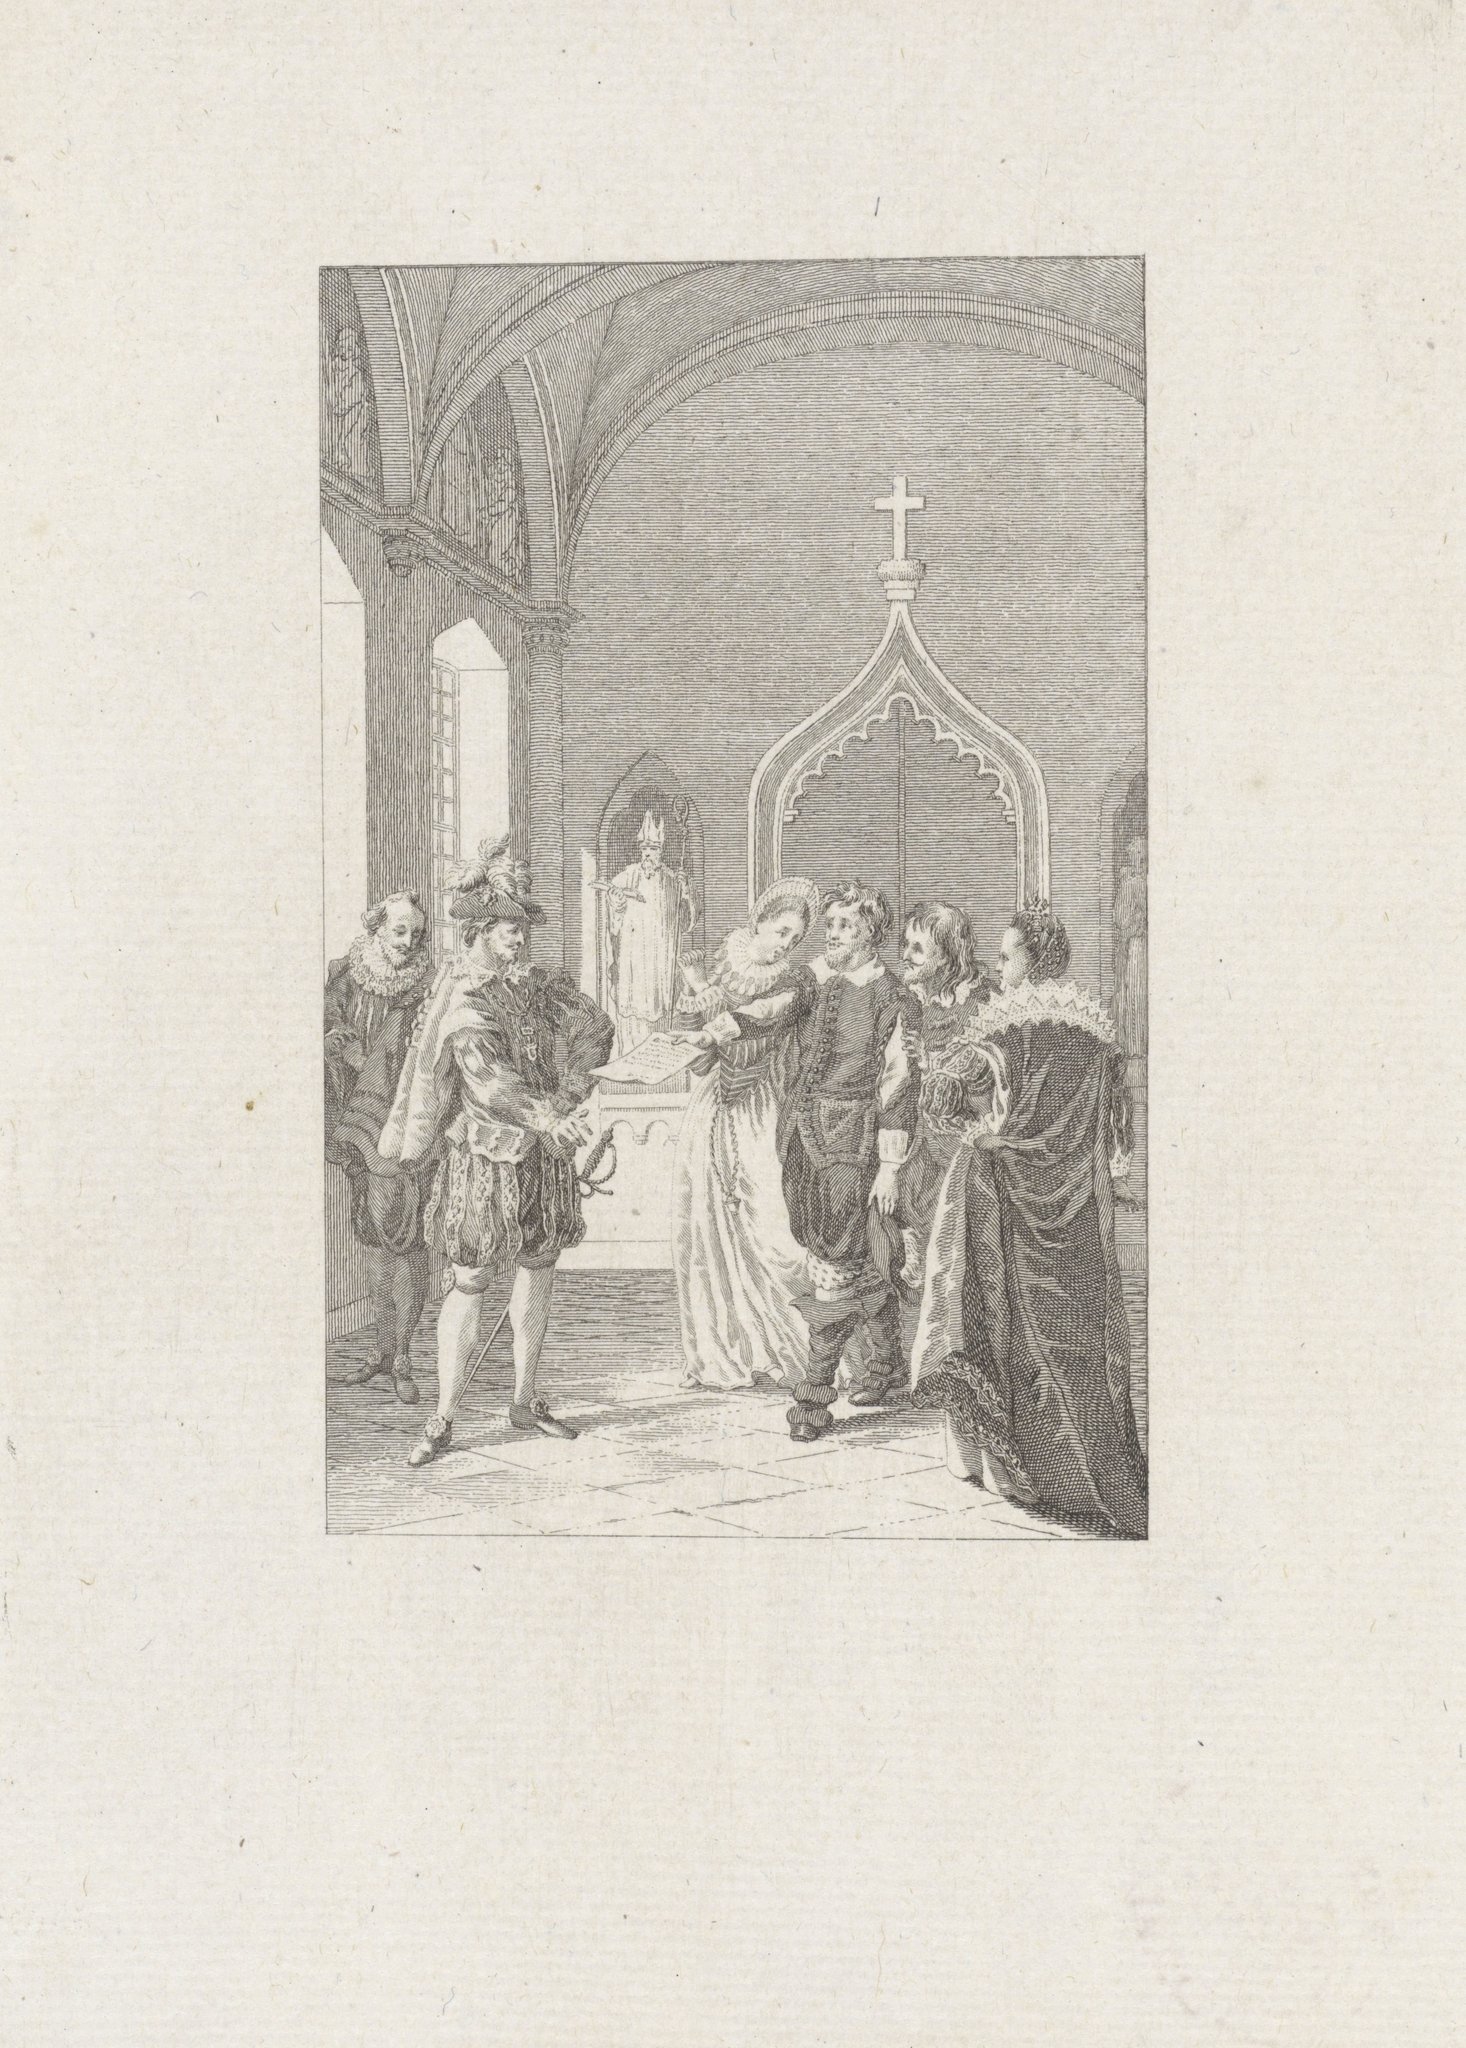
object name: print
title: Jacob Simonsz de Rijk geeft zijn ontslagbrief terug aan Cristóbal de Mondragón y Otalora terug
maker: reinier vinkeles (i)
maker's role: draughtsman, print maker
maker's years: 1741-1816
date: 1774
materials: paper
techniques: etching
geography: amsterdam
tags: cristóbal de mondragón y otalora, jacob simons de rijk, tachtigjarige oorlog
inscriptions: collector's mark: Lugt 240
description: Proefdruk van illustratie voor 'Jacob Simonszoon de Rijk' in: Winter-van Merken, L. W. van en N. S. van Winter. Tooneelpoëzy, Deel 1. Amsterdam: Pieter Meijer, 1774.